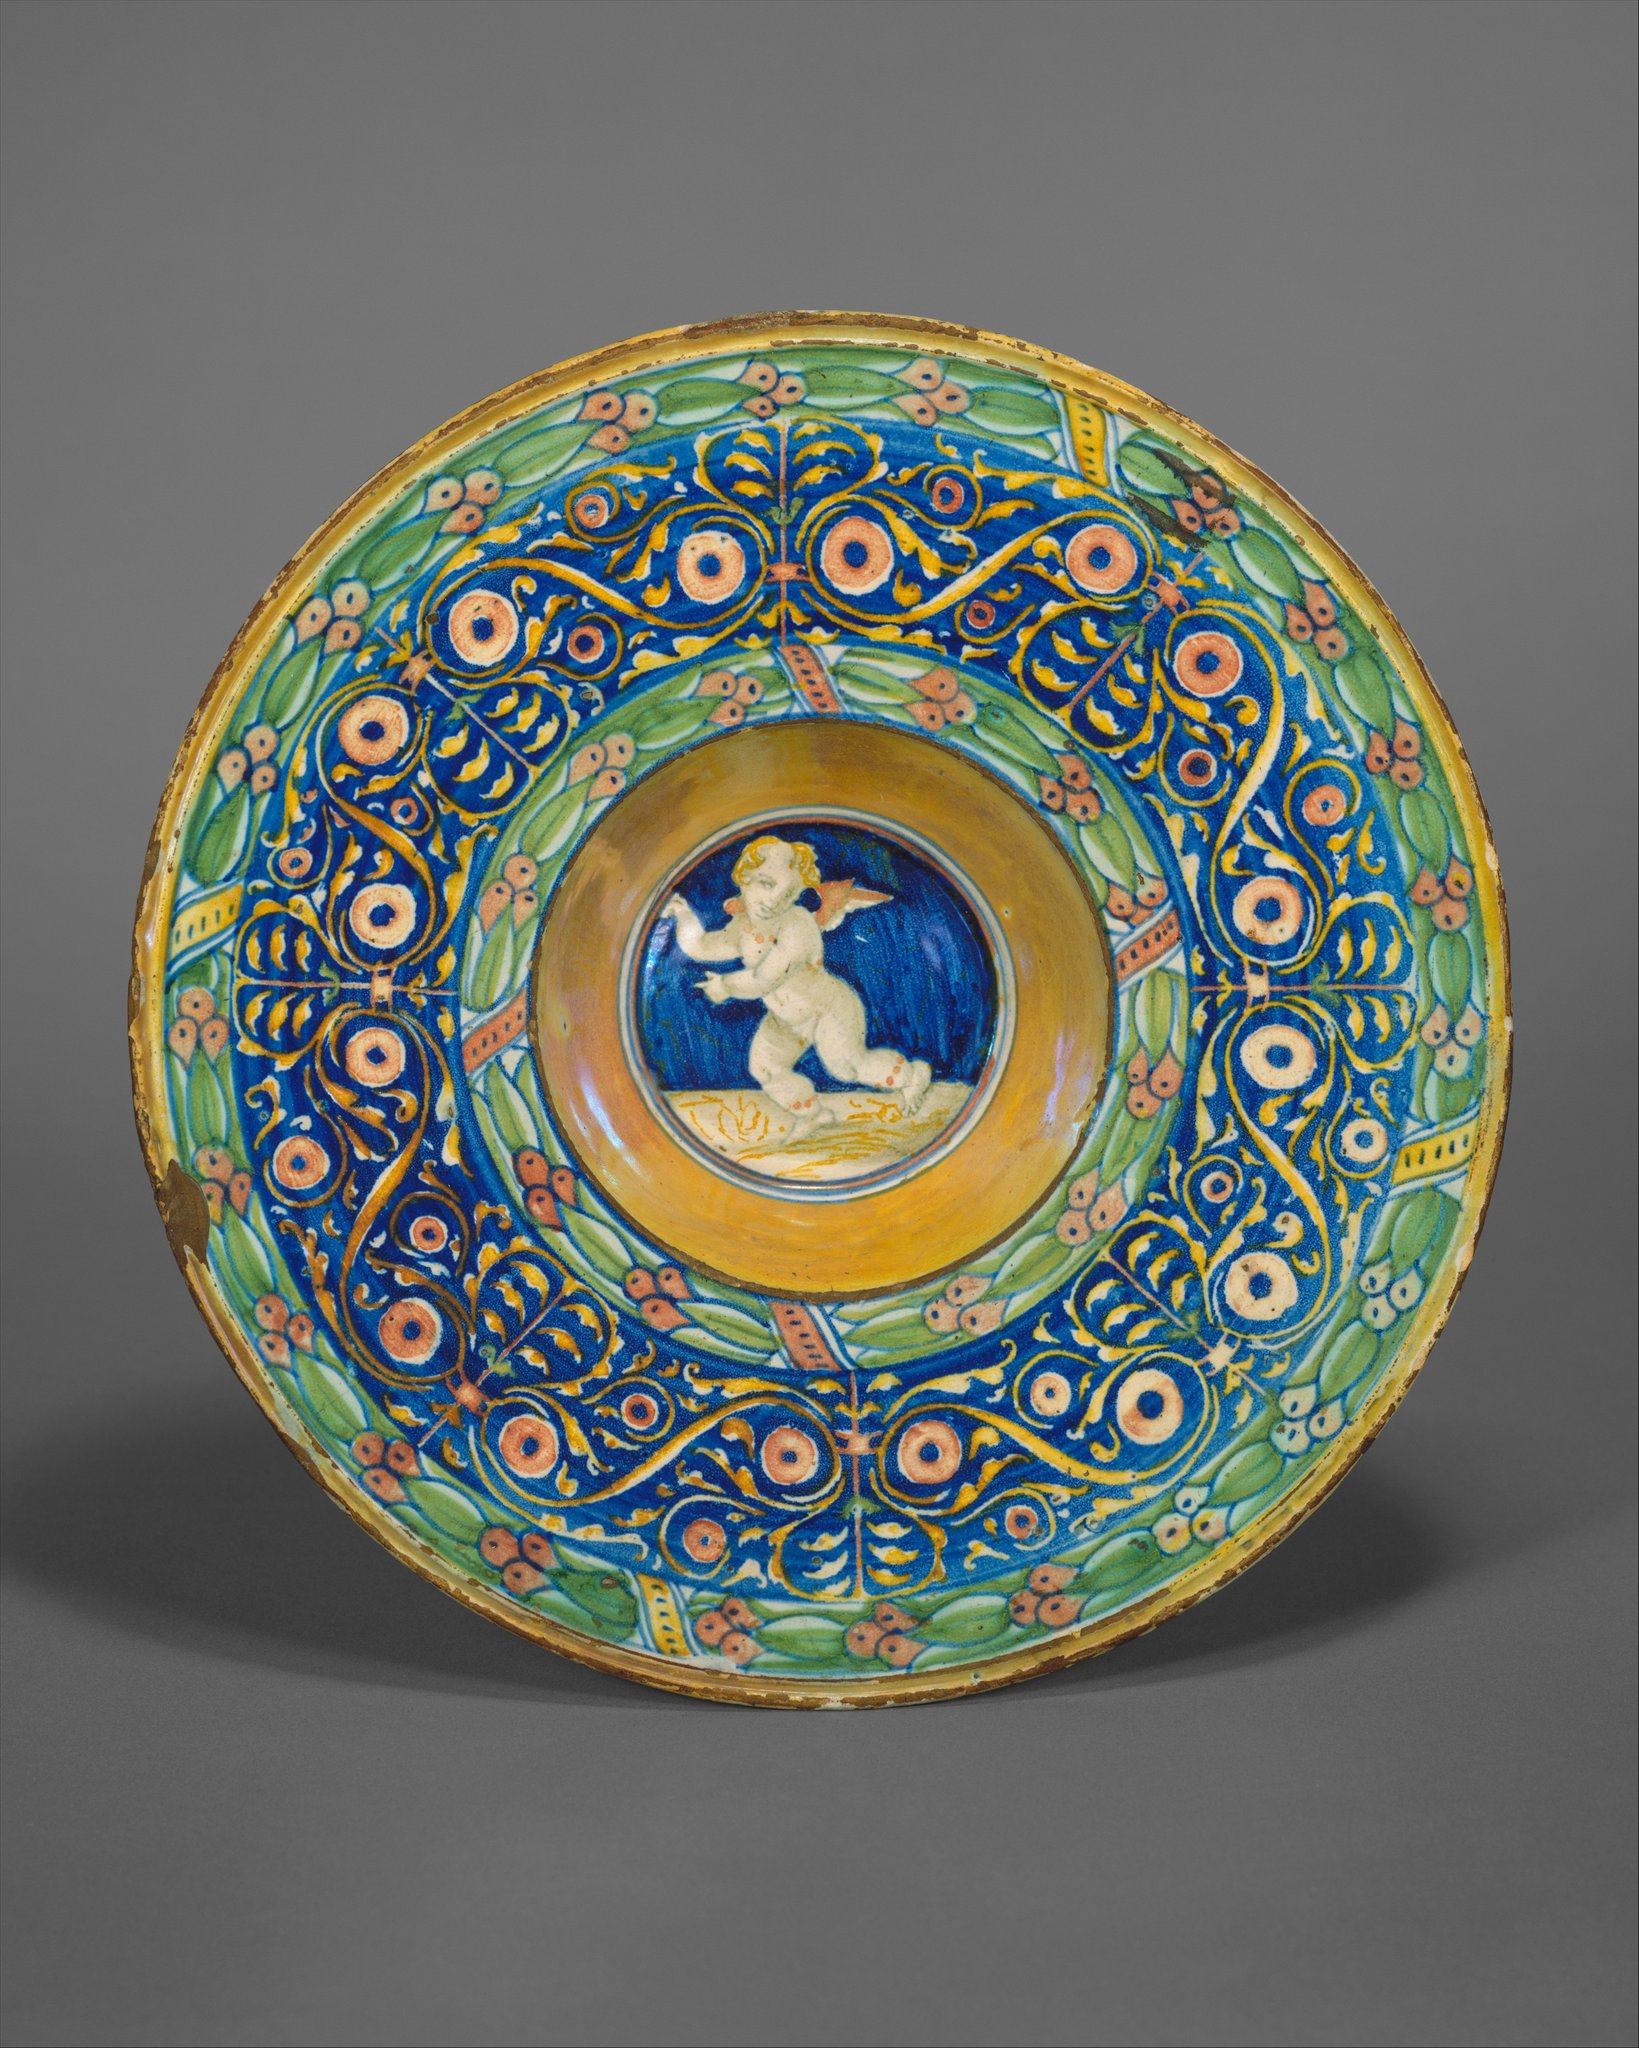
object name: plate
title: Plate (tondino)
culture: italian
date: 1525-1530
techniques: maiolica, glazing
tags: putti